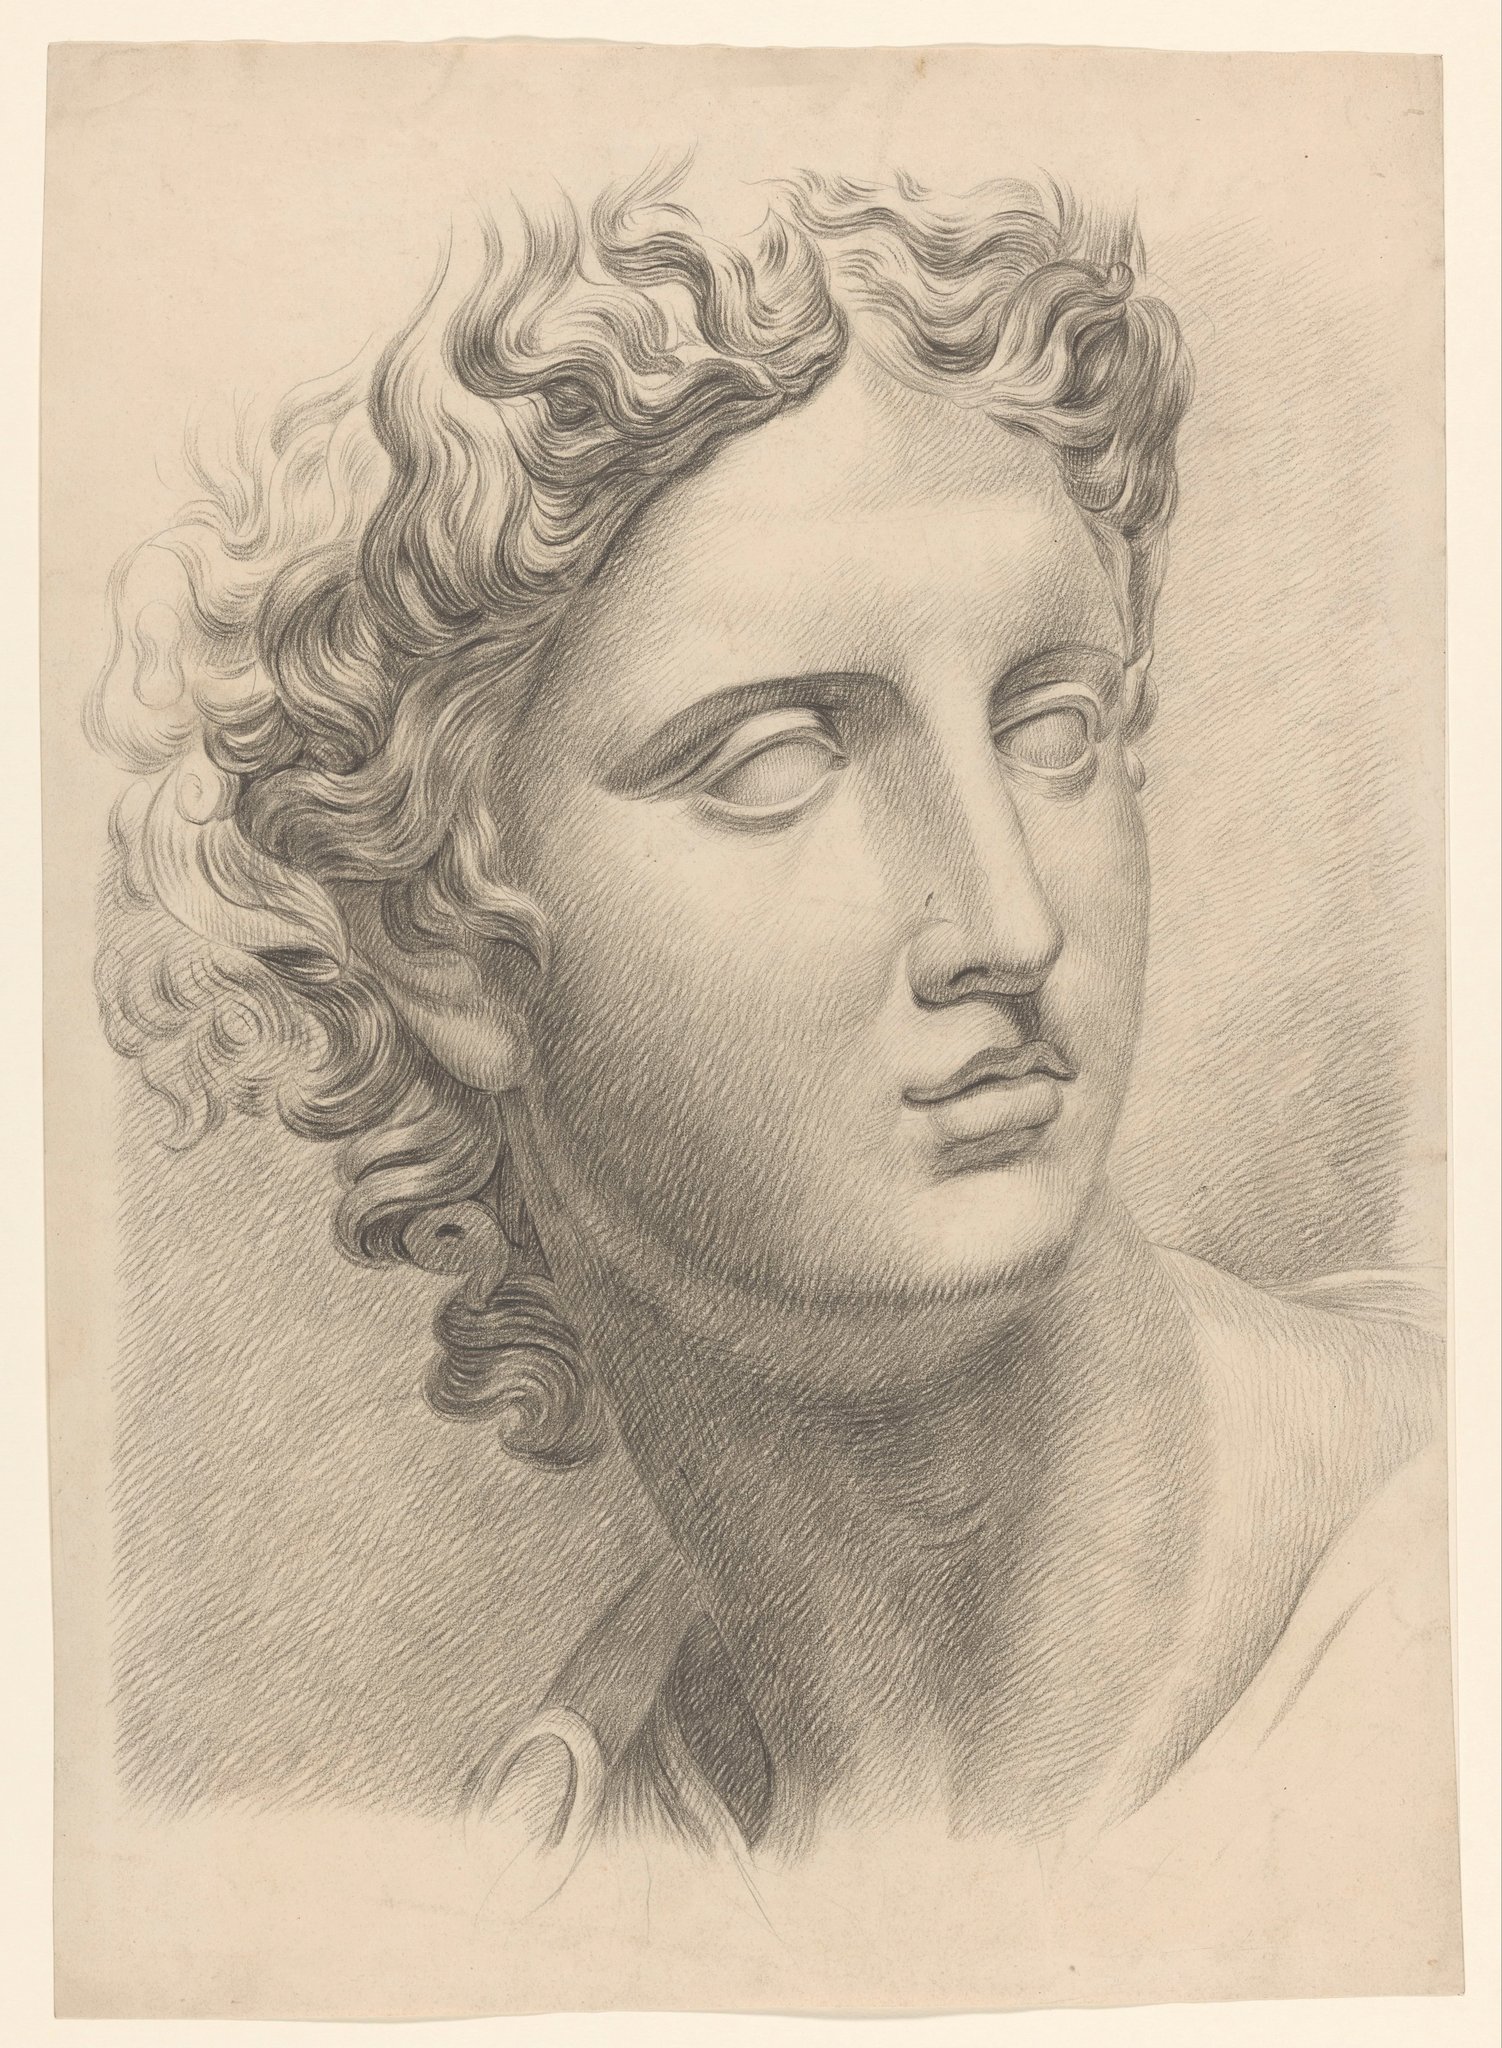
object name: drawing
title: Academiestudie naar een gips van een antiek beeld: manskop, naar rechts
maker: johannes tavenraat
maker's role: draughtsman, painter, print maker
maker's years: 1809-1881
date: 1819-1881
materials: chalk, paper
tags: piece of sculpture, reproduction of a piece of sculpture (+ ceramics ~ arts)